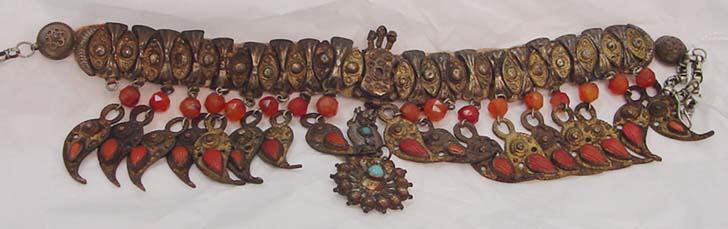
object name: necklace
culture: moroccan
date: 1801-1900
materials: amber, gemstone, cotton, metal